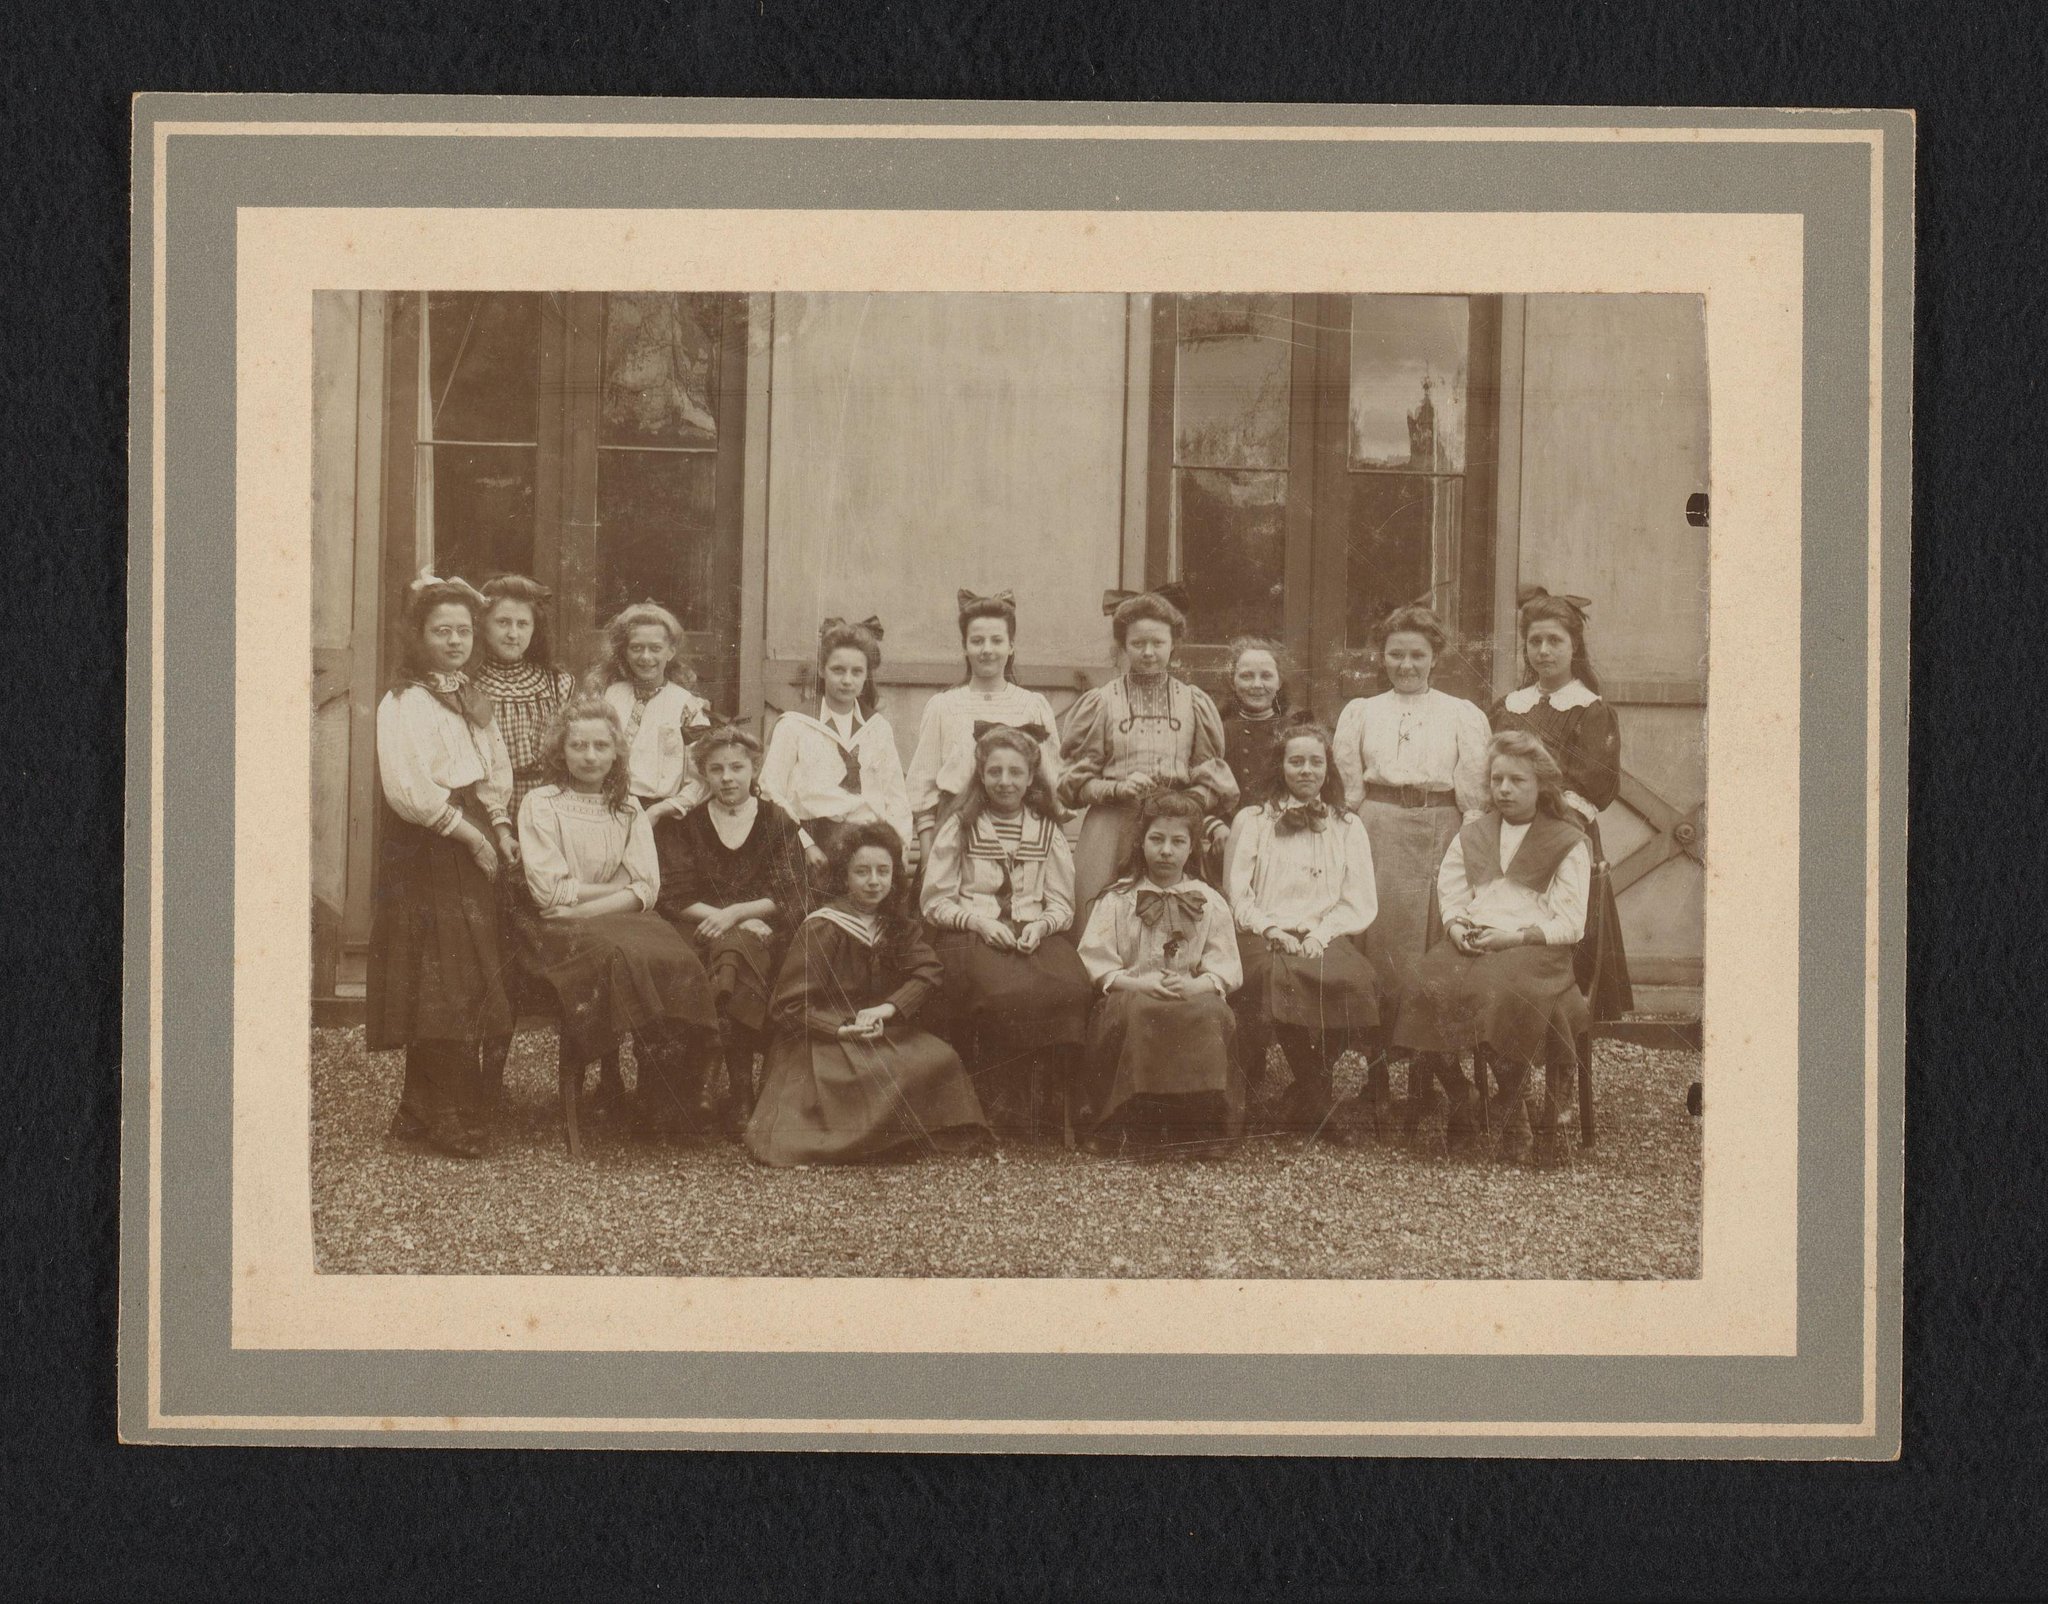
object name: cabinet photograph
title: Klassenfoto van de eerste klas van de HBS voor meisjes te Leiden in 1908, met Johanna (Hans) de Jong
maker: Anonymous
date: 1908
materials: paper, cardboard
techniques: collodion silver print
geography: leiden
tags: johanna petronella lambertina stokhuyzen-de jong (hans), secondary education, historical persons, leiden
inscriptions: inscription: ‘1908. Ie klasse meisjes HBS Leiden./ Staande van links naar rechts:/ ? ? Annie Huisman. Hans de Jong. Luus van Selden./ Frieda van Bruro. Liesje van Griethuizen. ? Marie Sträter./ Zittend van links naar rechts:/ Toos Meerburg./ Marie [...] Dientje [...]aape. Annie Goud-/ smit. Be' van Hamel. Nella Lothy. Bep van Walsum.’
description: Vierde meisje van links op de bovenste rij is Johanna (Hans) de Jong.